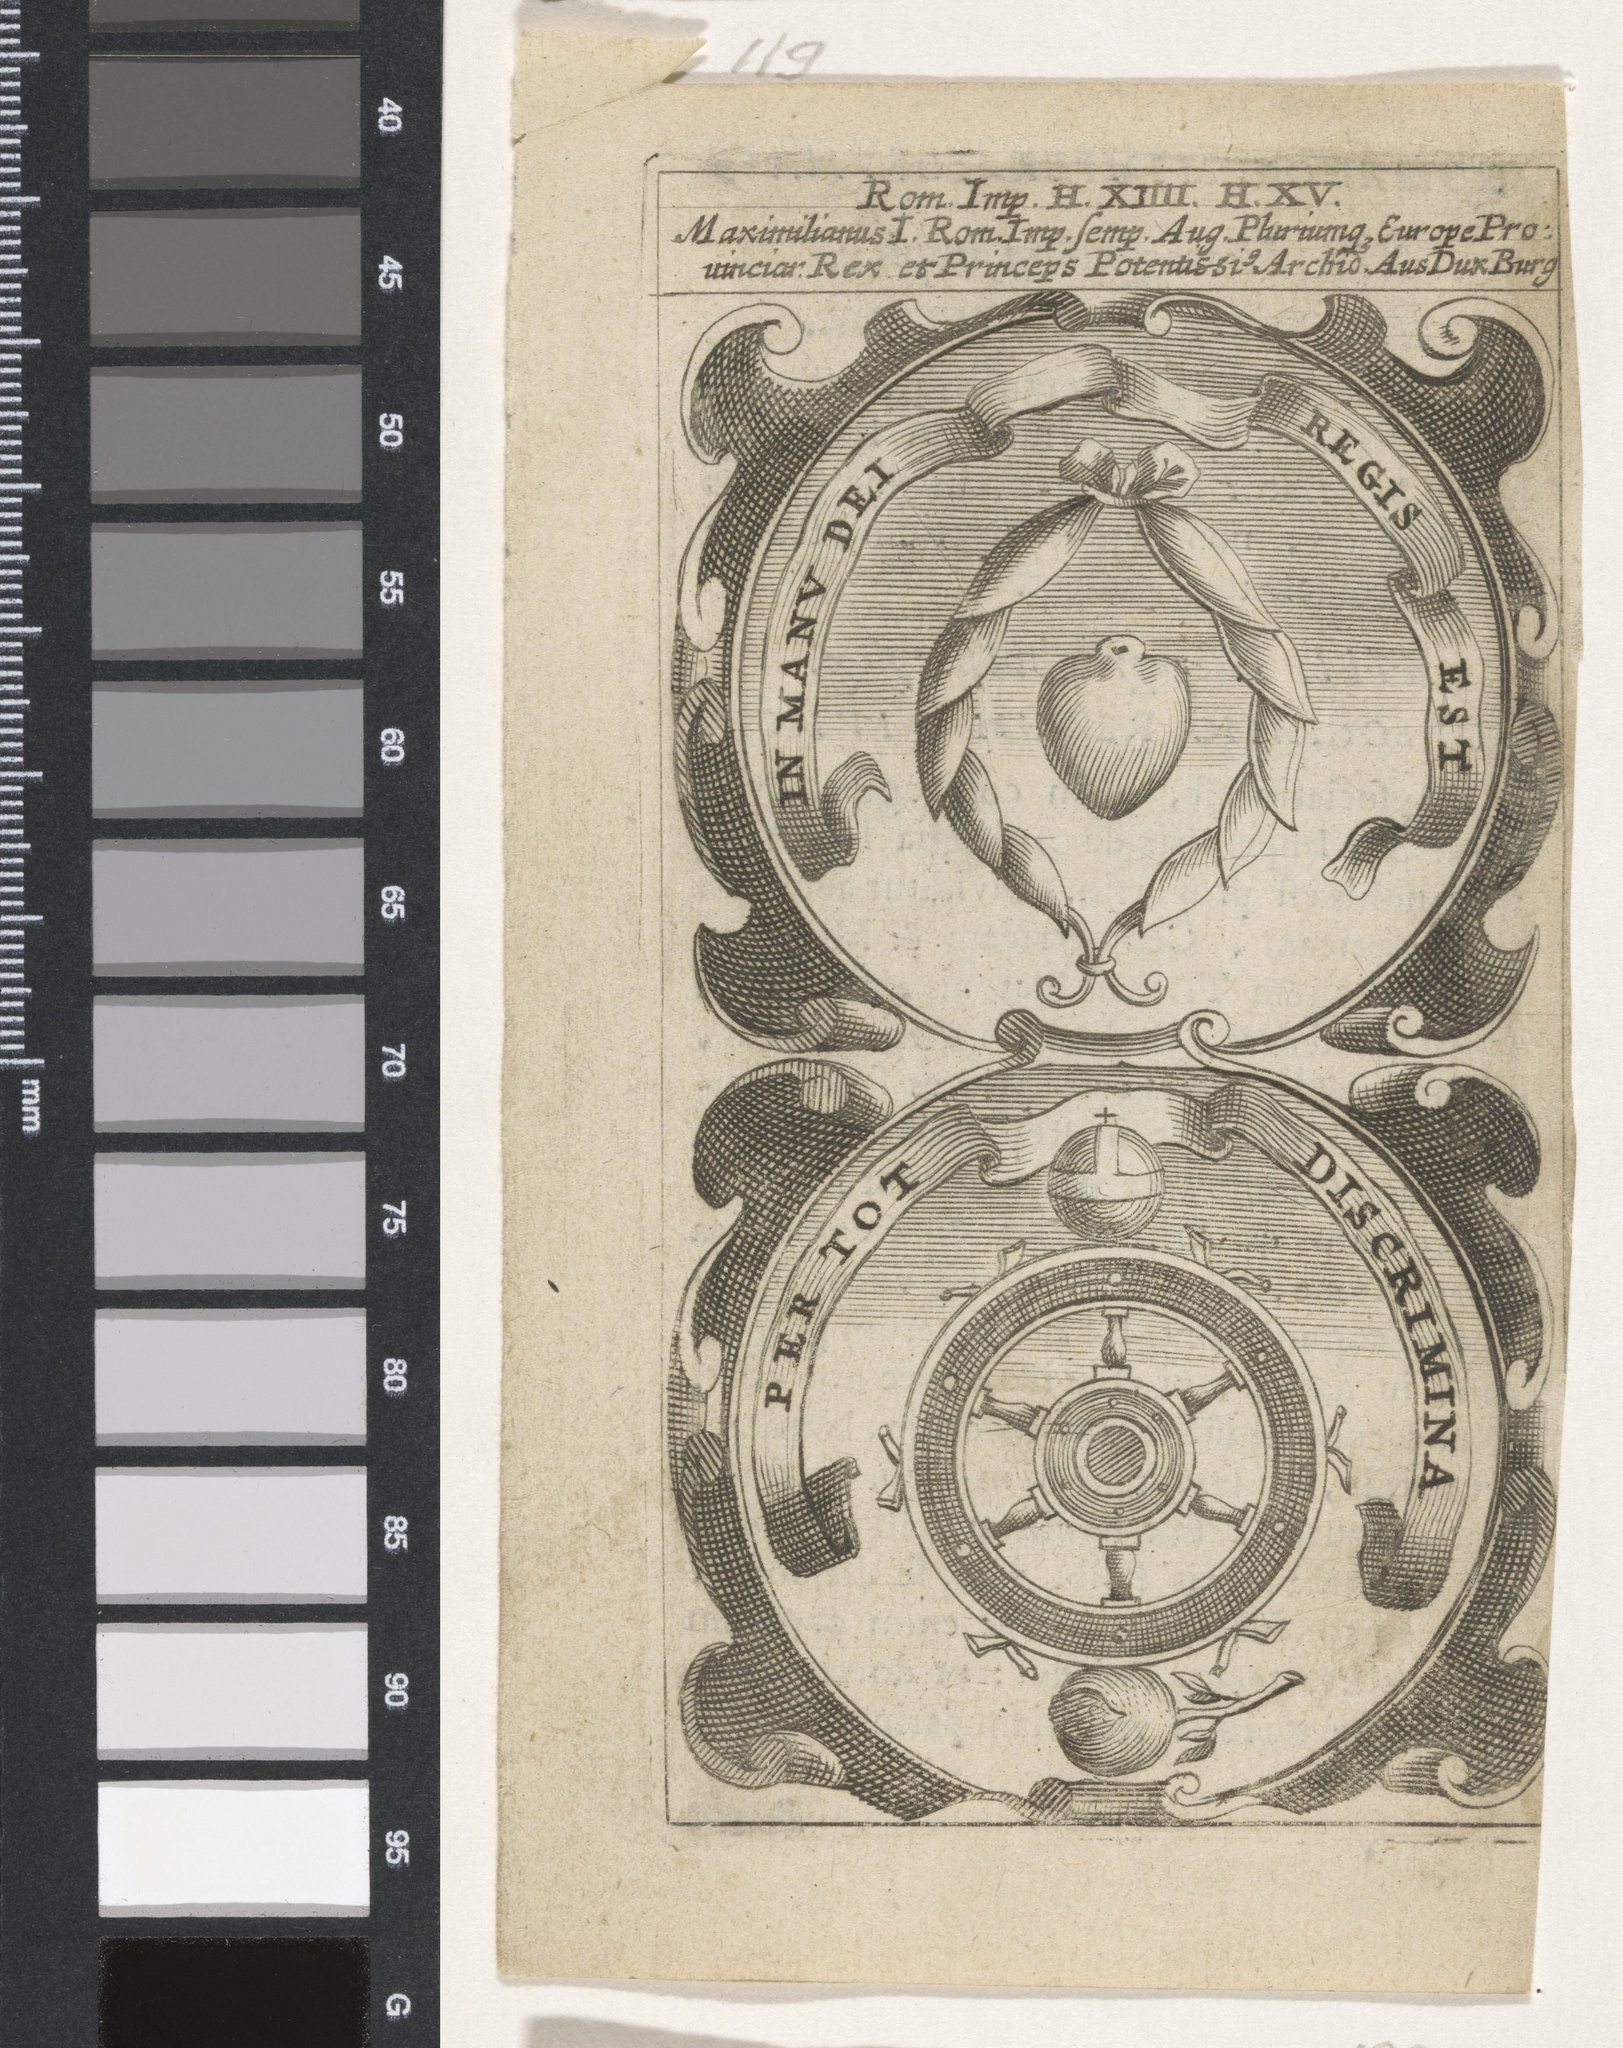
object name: print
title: Lauwerkrans met hart / Rad van Fortuin met rijksappel en roos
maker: Anonymous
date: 1666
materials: paper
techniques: engraving, letterpress printing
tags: maximilian i (holy roman emperor), orb (symbol of sovereignty; sphere with cross on top), garland, wreath, turn of fate, wheel of fortune, flowers: rose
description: Pagina uit Jacob Typotius, Symbola Divina & Humana Pontificum Imperatorum Regum. Arnhem, J.F. Hagen, 1666 of uit de titeluitgave van 1669 of 1679. Het werk van Typotius werd voor het eerst uitgegeven in 1601 met prenten van Aegidius Sadeler.